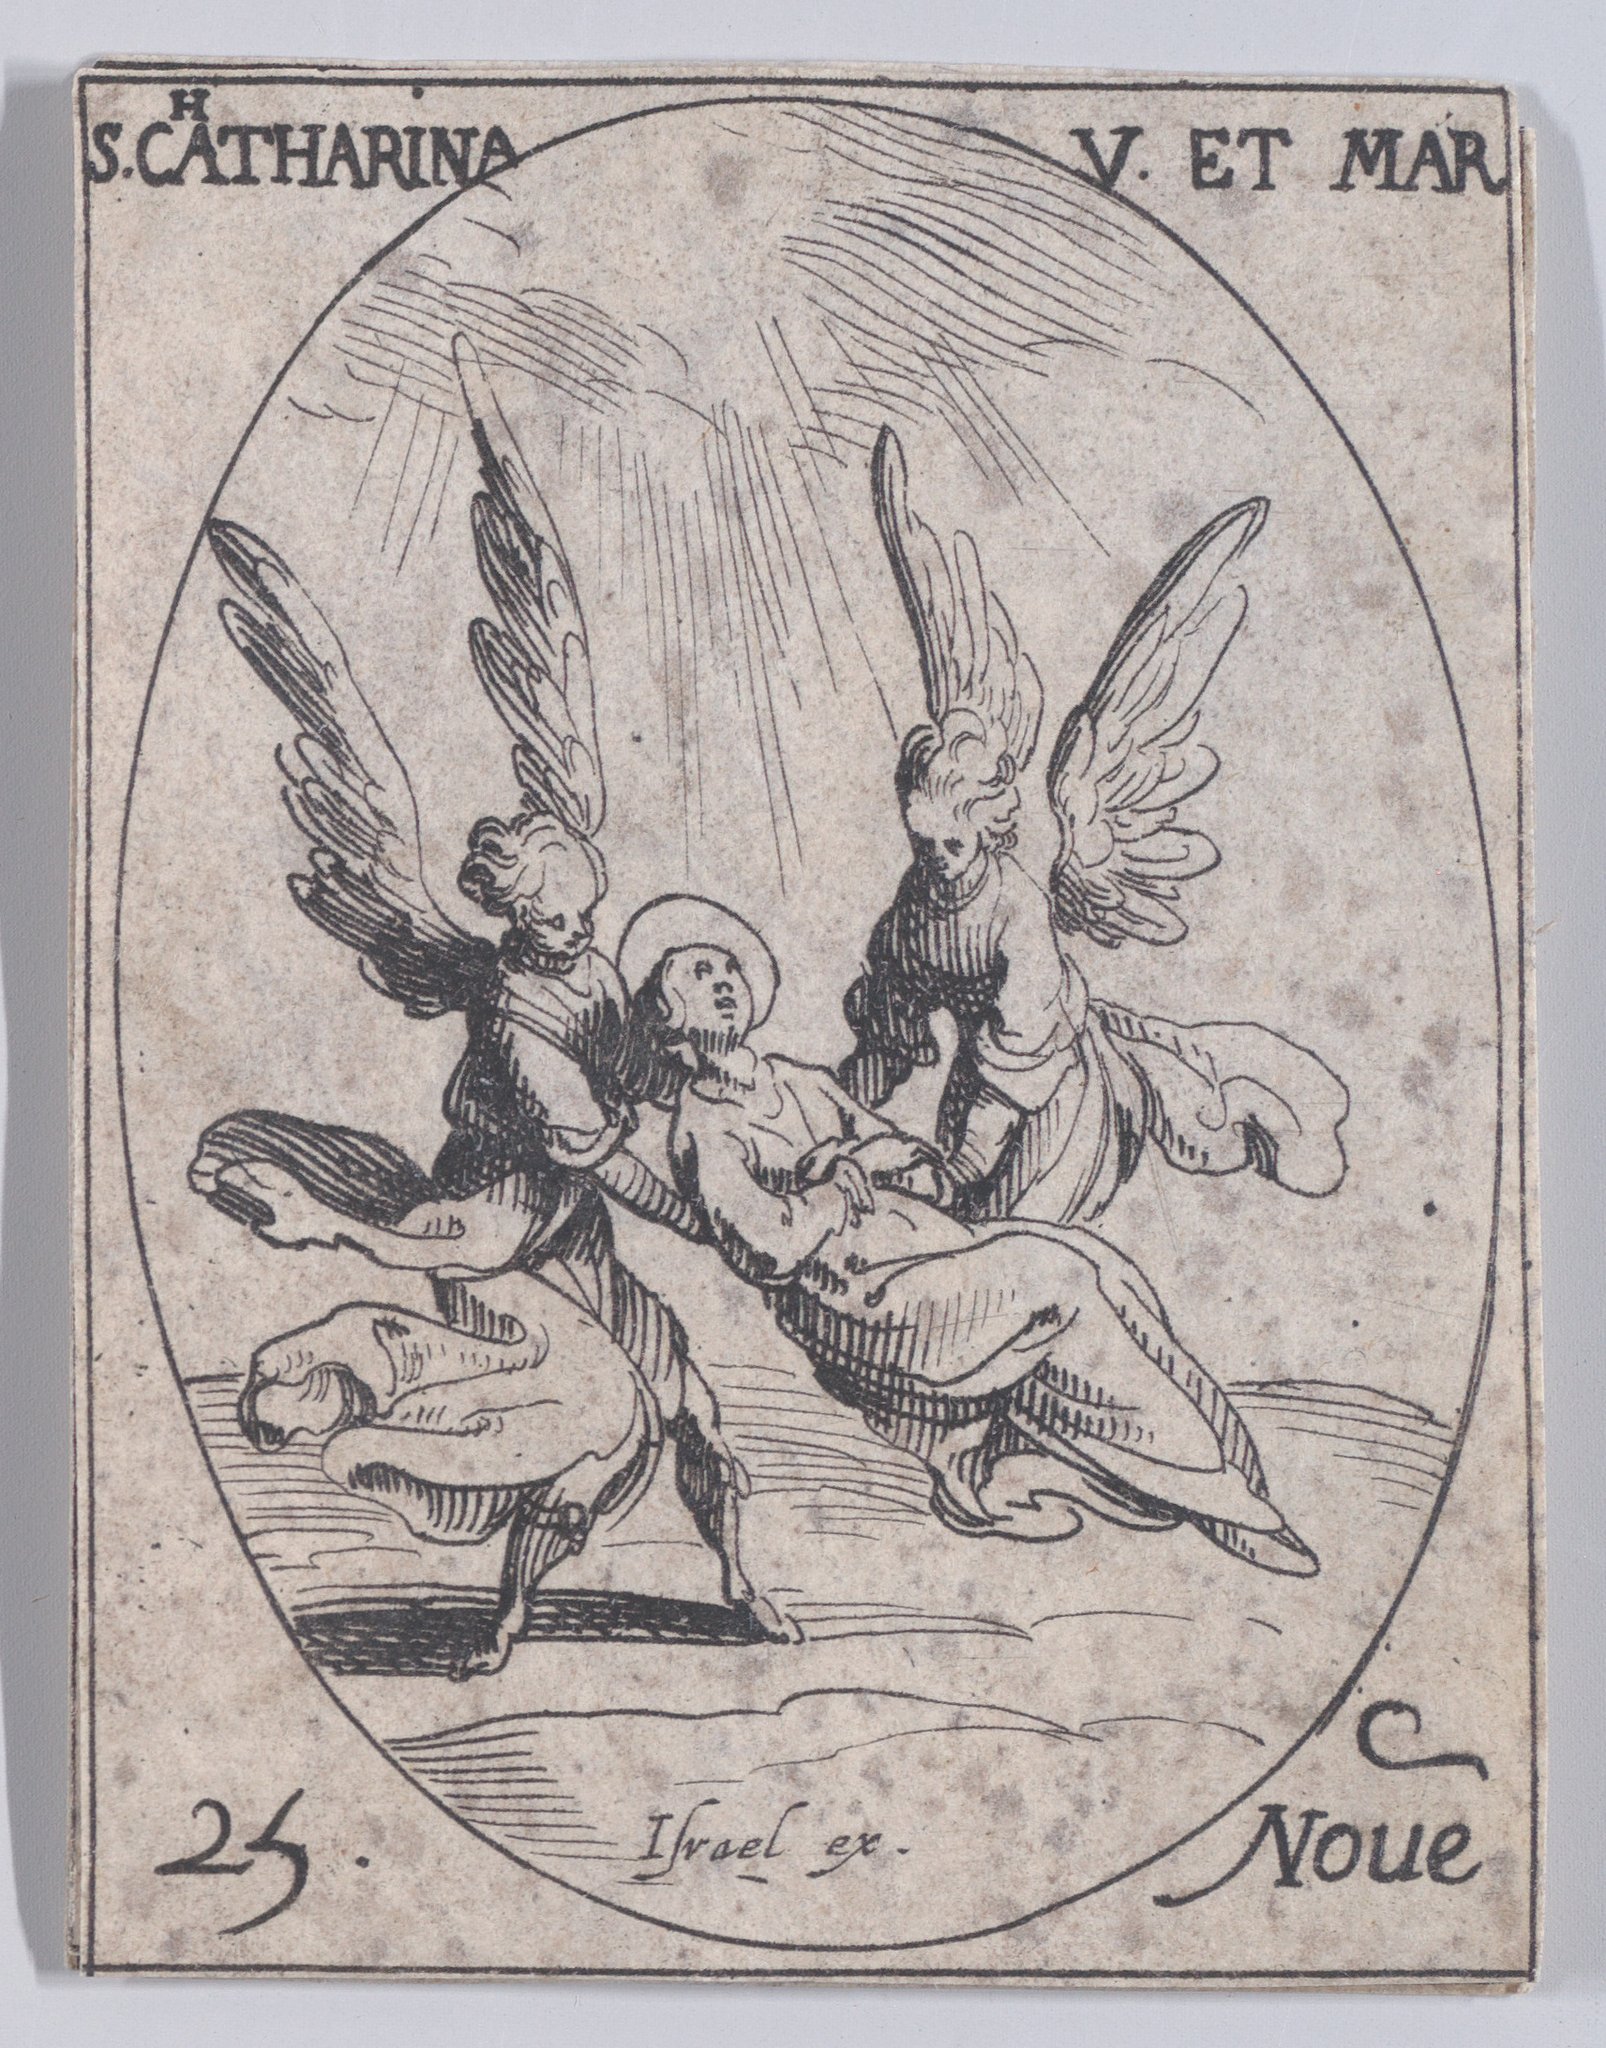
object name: print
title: Ste. Catherine, vierge et martyre (St. Catherine, Virgin and Martyr), November 25th, from "Les Images De Tous Les Saincts et Saintes de L'Année" (Images of All of the Saints and Religious Events of the Year)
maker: jacques callot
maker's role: artist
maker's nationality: french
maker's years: 1592-1635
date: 1636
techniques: etching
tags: women,angels,saints